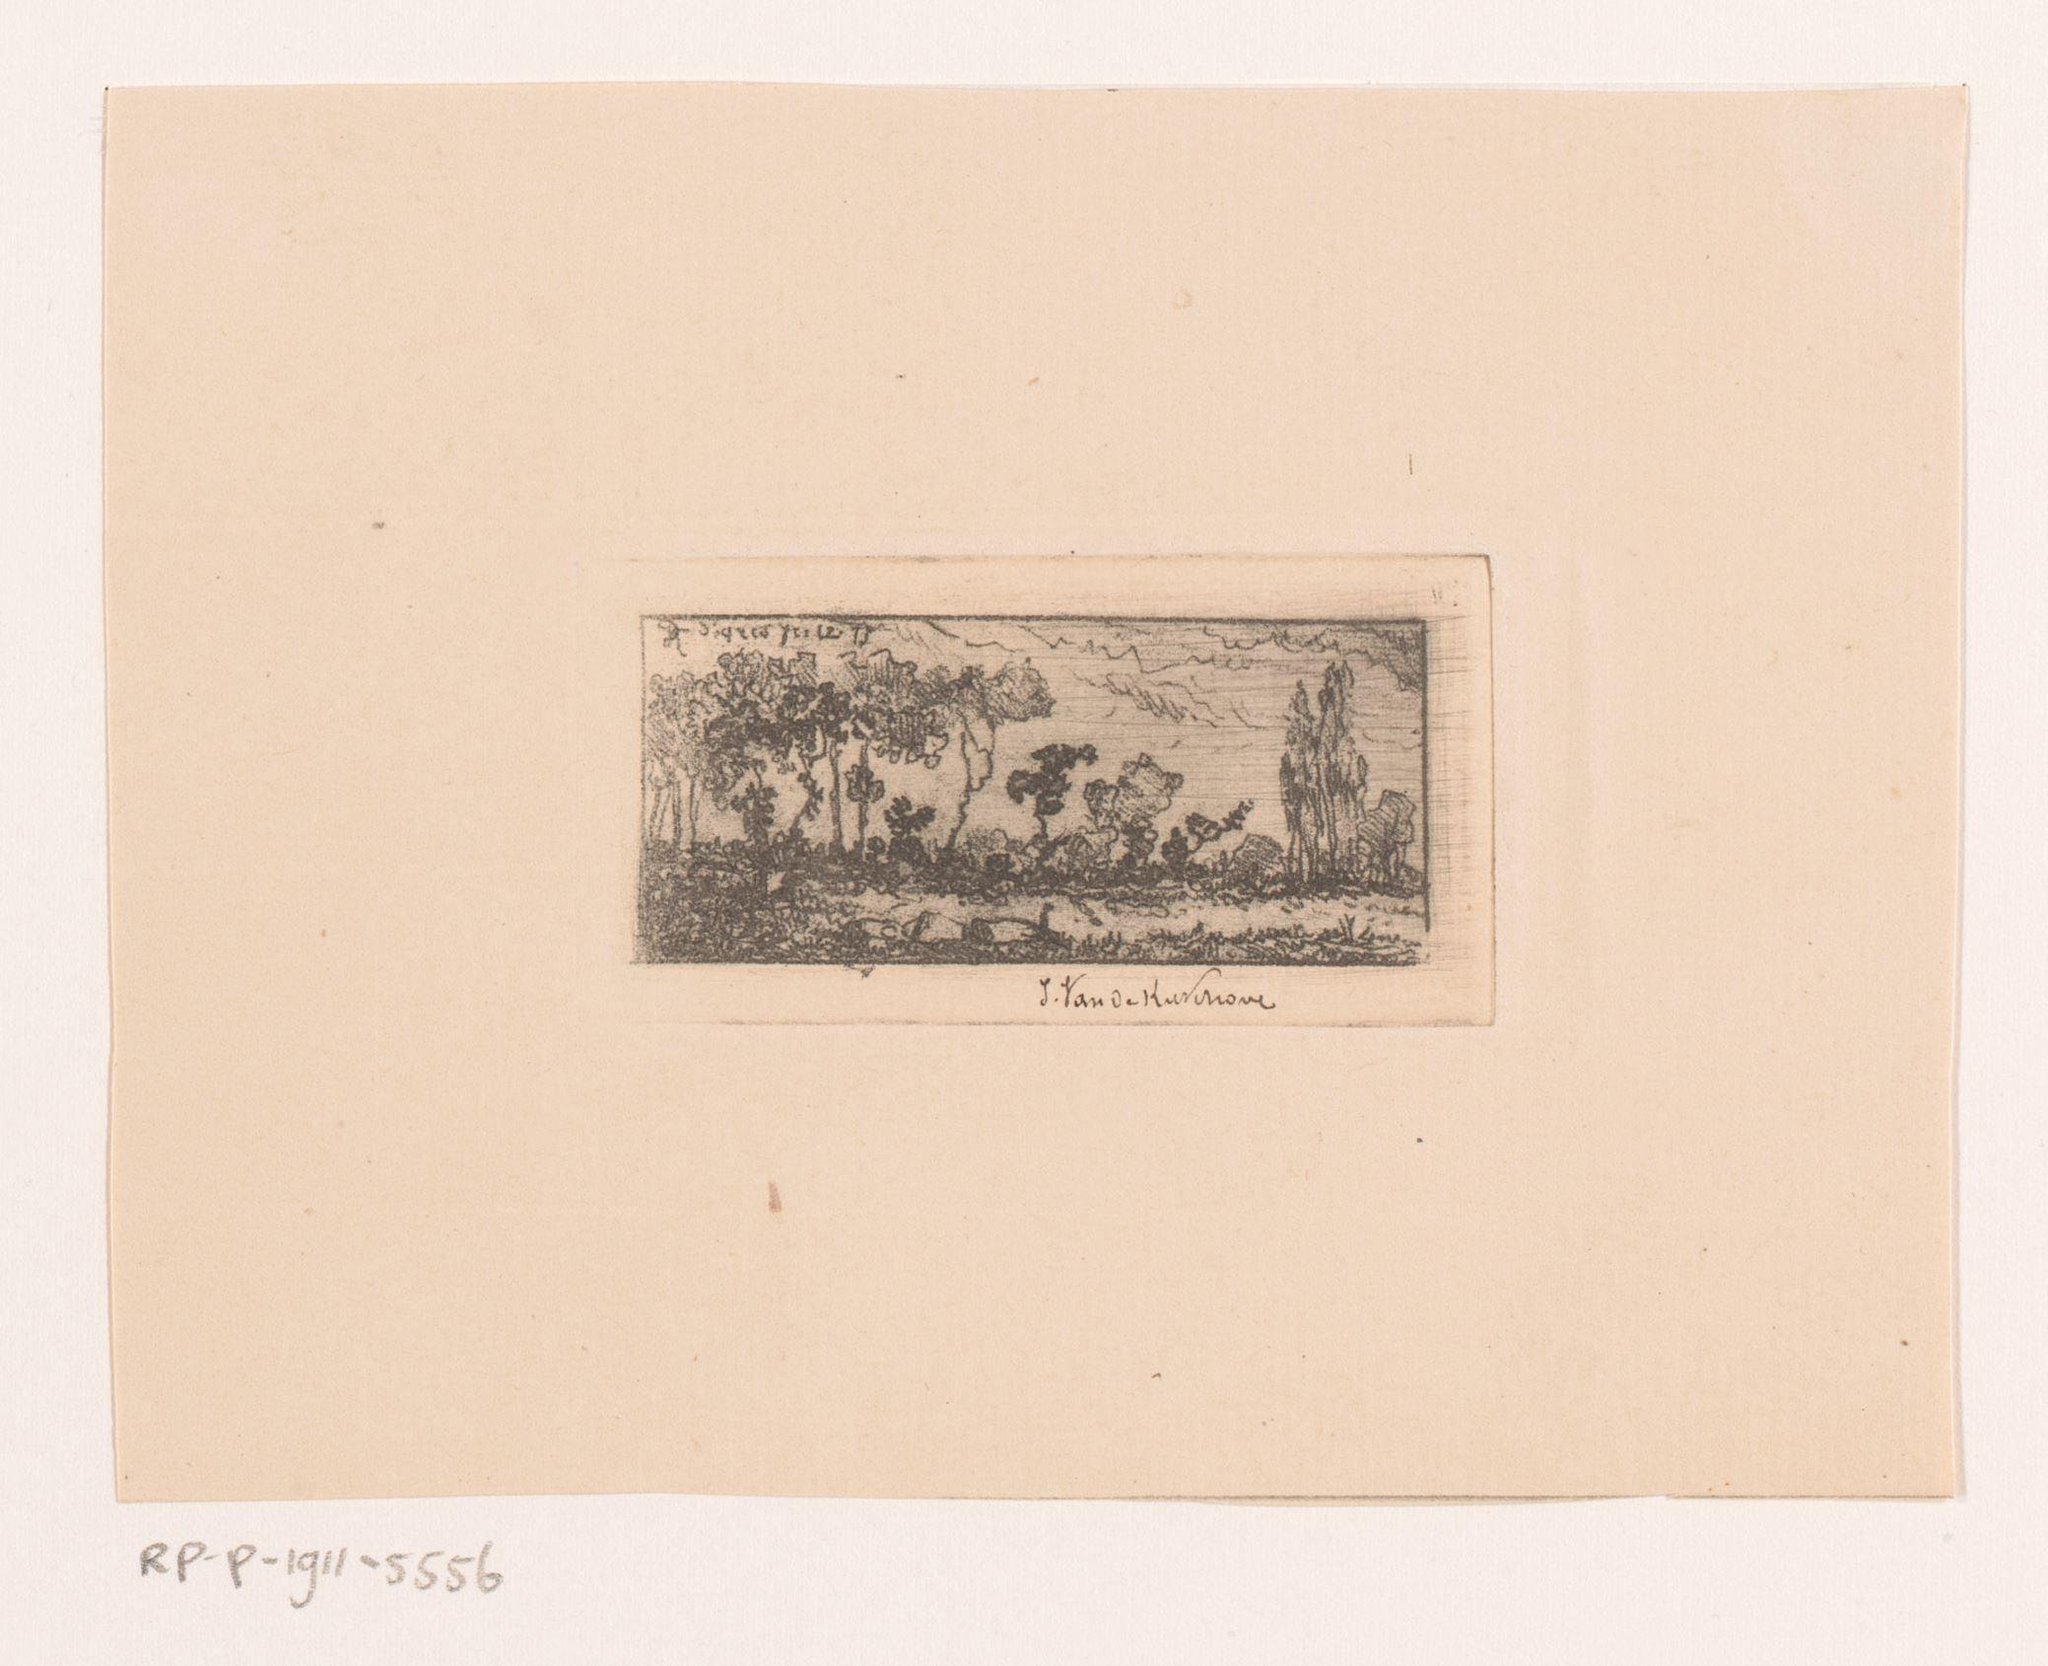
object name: print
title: Boomrijk landschap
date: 1873-1881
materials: paper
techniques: drypoint, etching, intaglio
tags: landscapes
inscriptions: collector's mark: Lugt 2228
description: De etsen naar de schilderijen van Frédéric Van de Kerkhove werden na zijn dood door zijn vader en zuster gemaakt en uitgegeven in twee reeksen. De eerste werd in 1877 uitgegeven door het Journal des Beaux-Arts et de la Littérature: Cahier de 25 Eaux-fortes d'après Frédéric van de Kerkhove, gravées par son père et sa sœur. De tweede reeks van 126 etsen, ook in 1877, werd in Parijs uitgegeven bij A. Lévy onder de titel Cent eaux-fortes gravées par J. Van de Kerkhove d'après les tableaux de Frédéric Van de Kerkhove, mort en 1873 à l'âge de 10 ans et 11 mois.